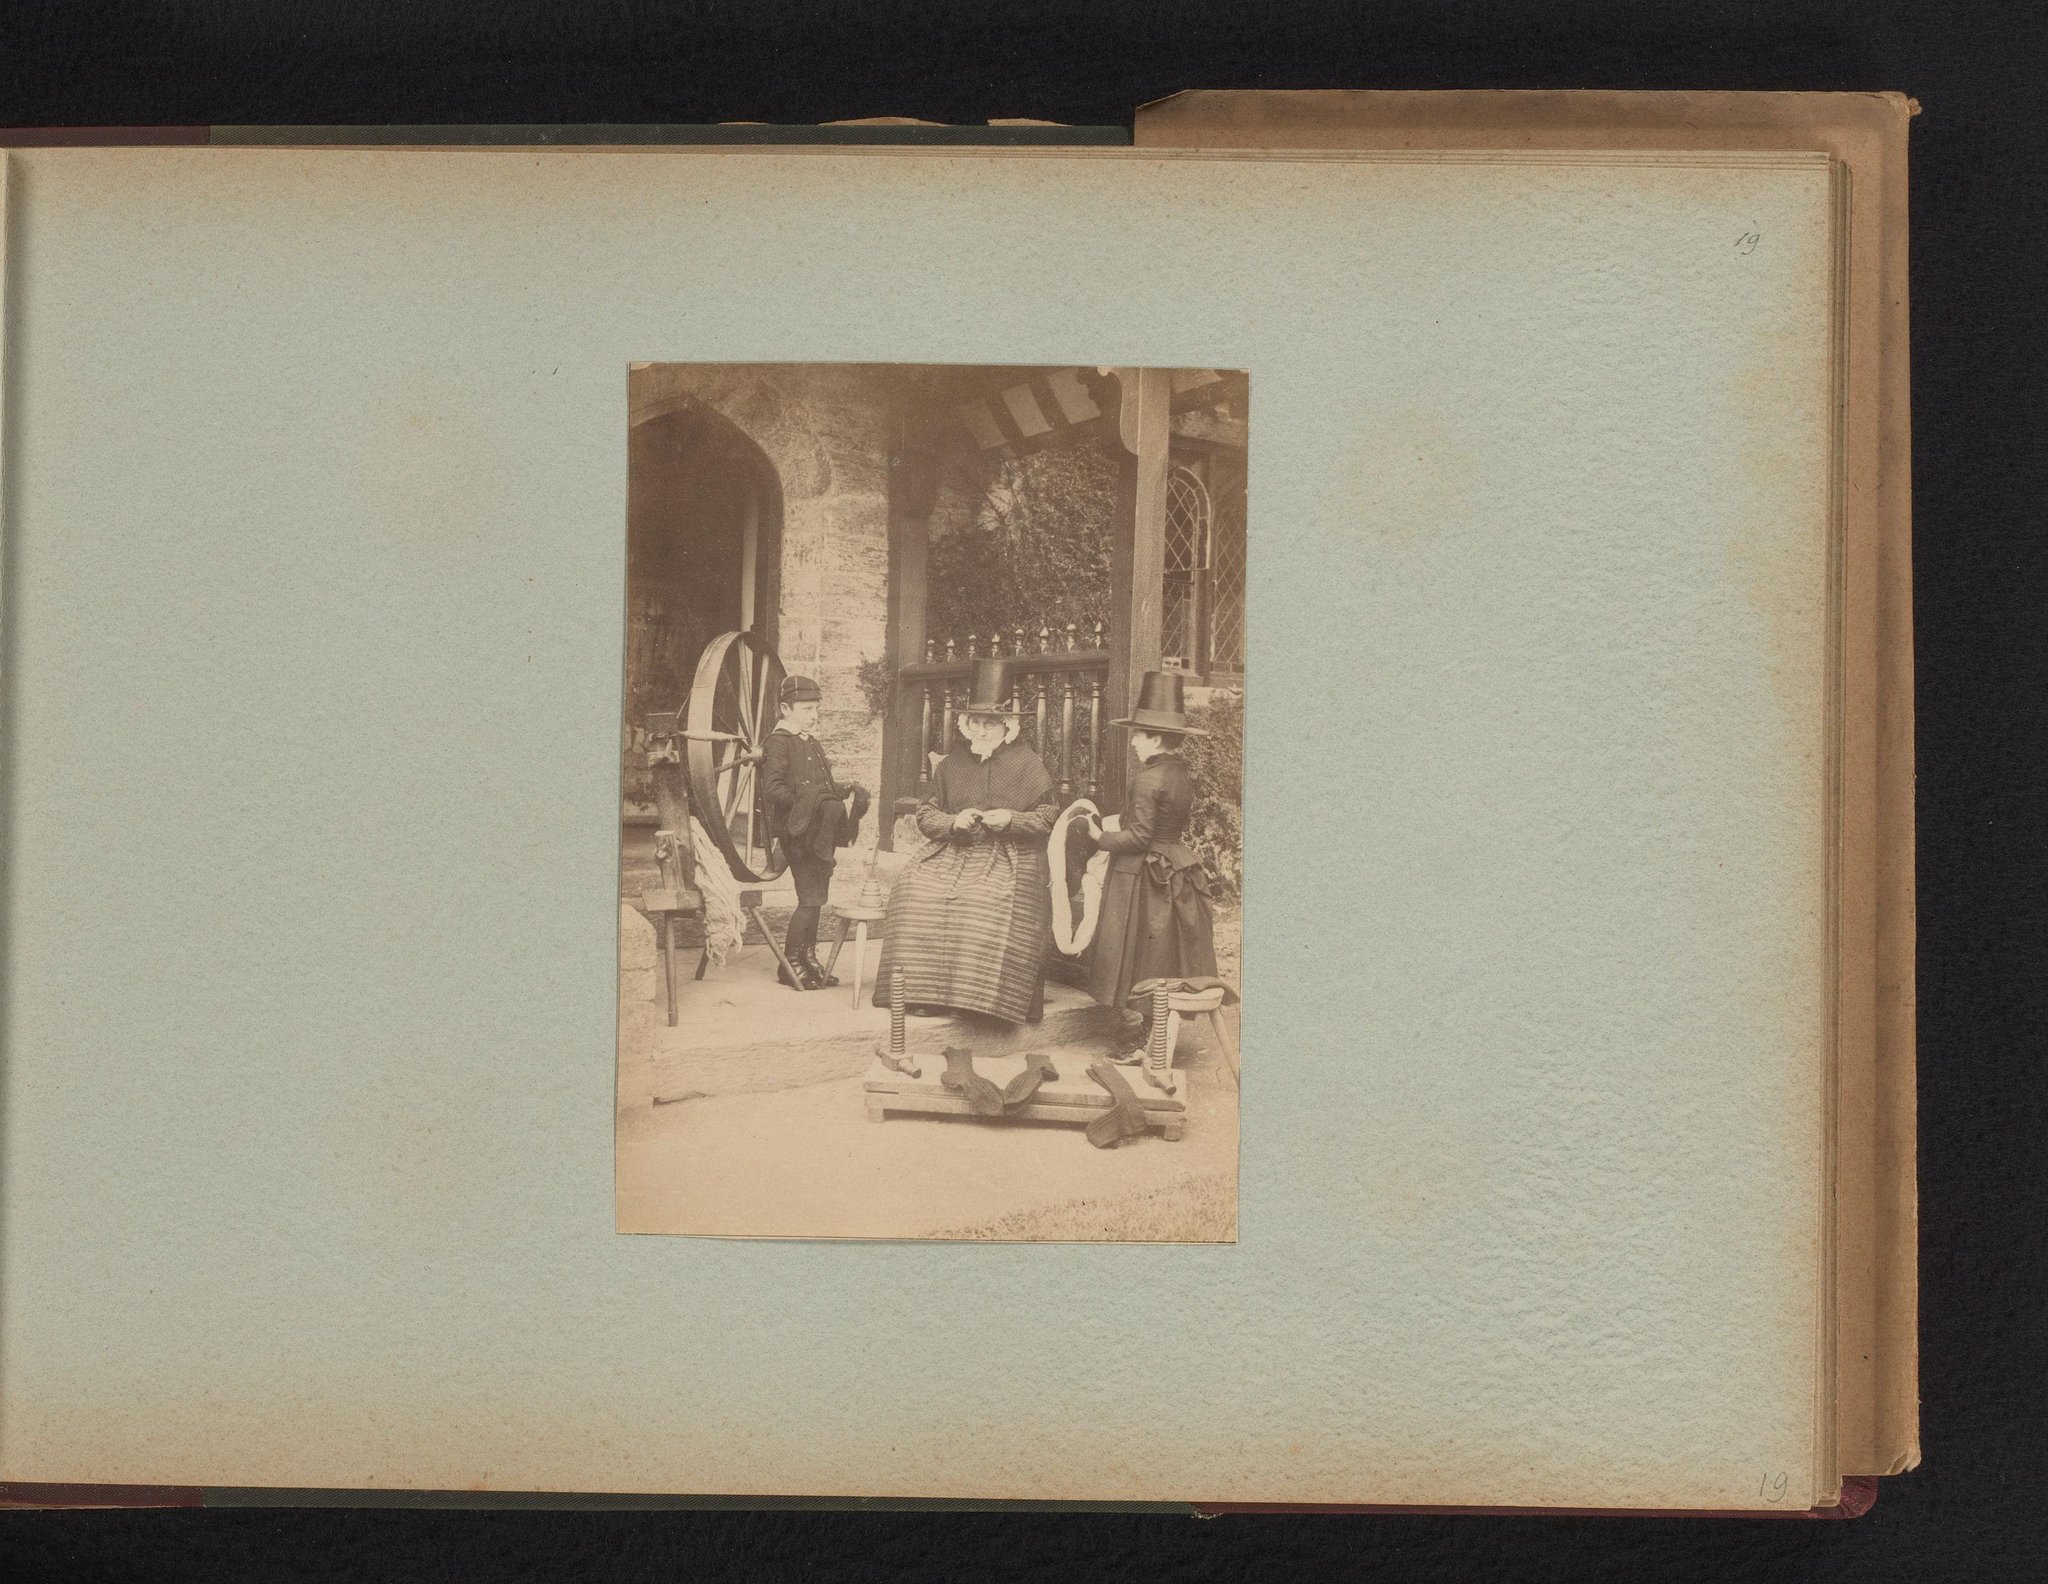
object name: album leaf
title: Vrouw breit sokken naast een spinnewiel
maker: Anonymous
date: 1851-1880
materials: paper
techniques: albumen print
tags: adult woman, child, spinning-wheel, knitting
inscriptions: number: ‘19’